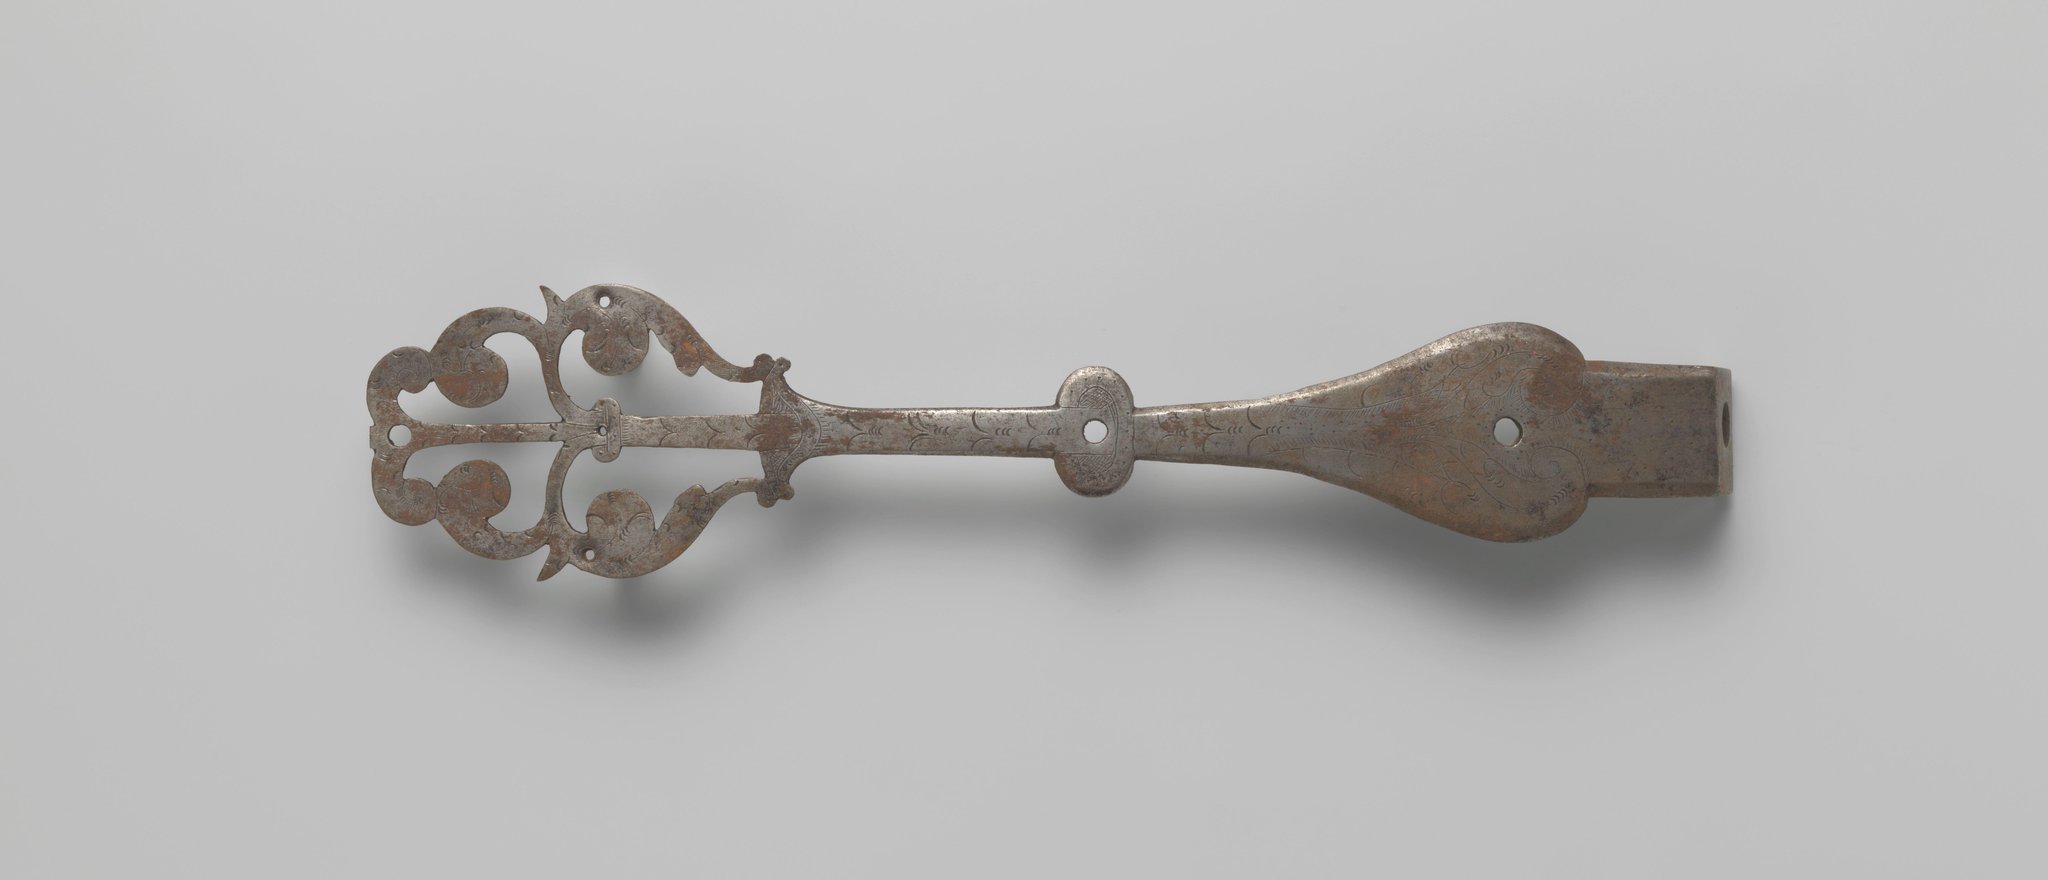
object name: door fitting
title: Onderdeel van een deurhengsel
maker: Anonymous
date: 1600-1800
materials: iron, tin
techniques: engraving, forging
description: Deurbeslag van vertind ijzer, onderdeel van een deurhengsel, versierd met graveringen. Het beslag is vanaf het scharnier als volgt: een balustervormig begin, overgaand in een smal, recht stuk waaruit naar het einde toe enkele bladmotieven ontspringen, die als voluten omkrullen. Het geheel eindigt in een puntig blad.